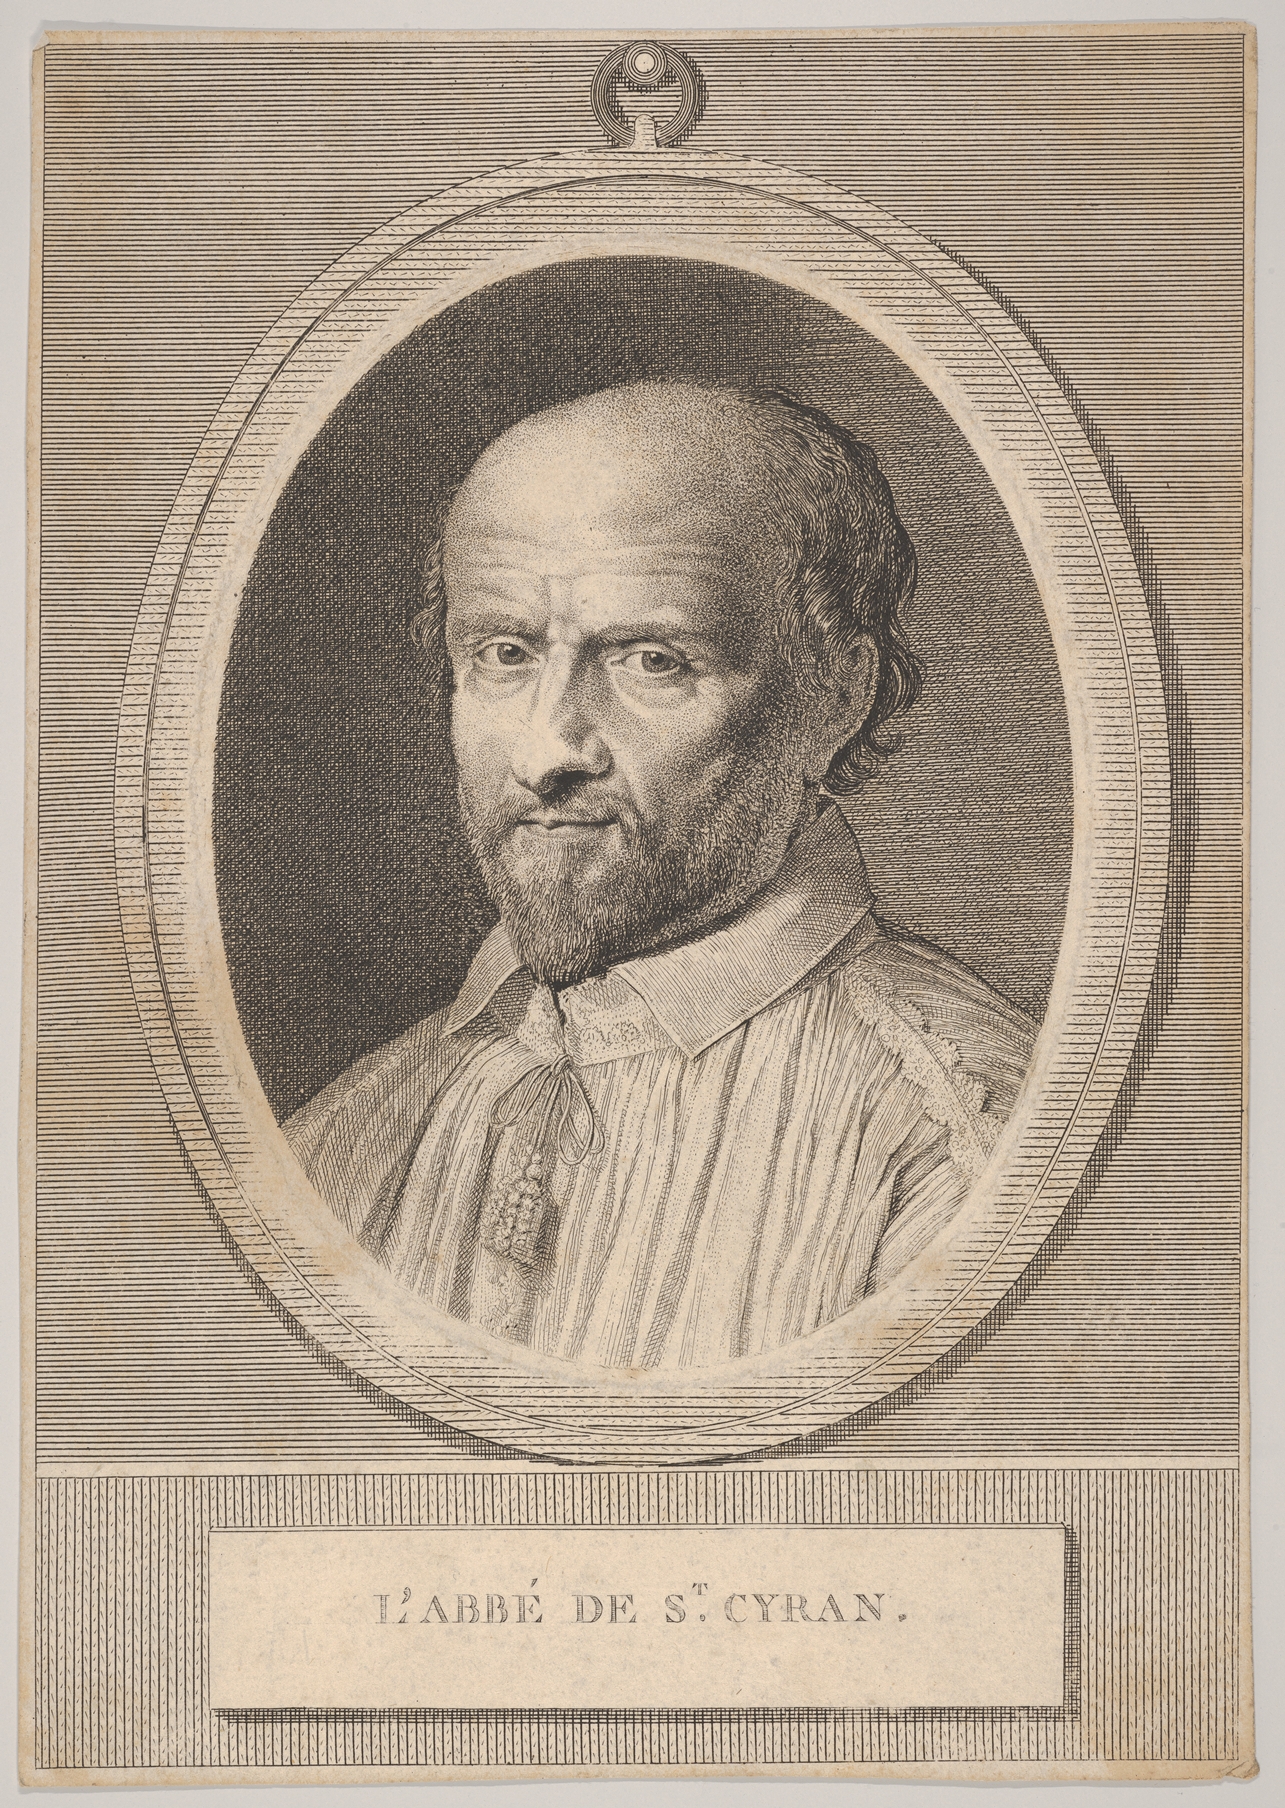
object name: print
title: L'Abbé de Saint Cyran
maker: Anonymous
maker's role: artist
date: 1615-1700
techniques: engraving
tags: men,portraits